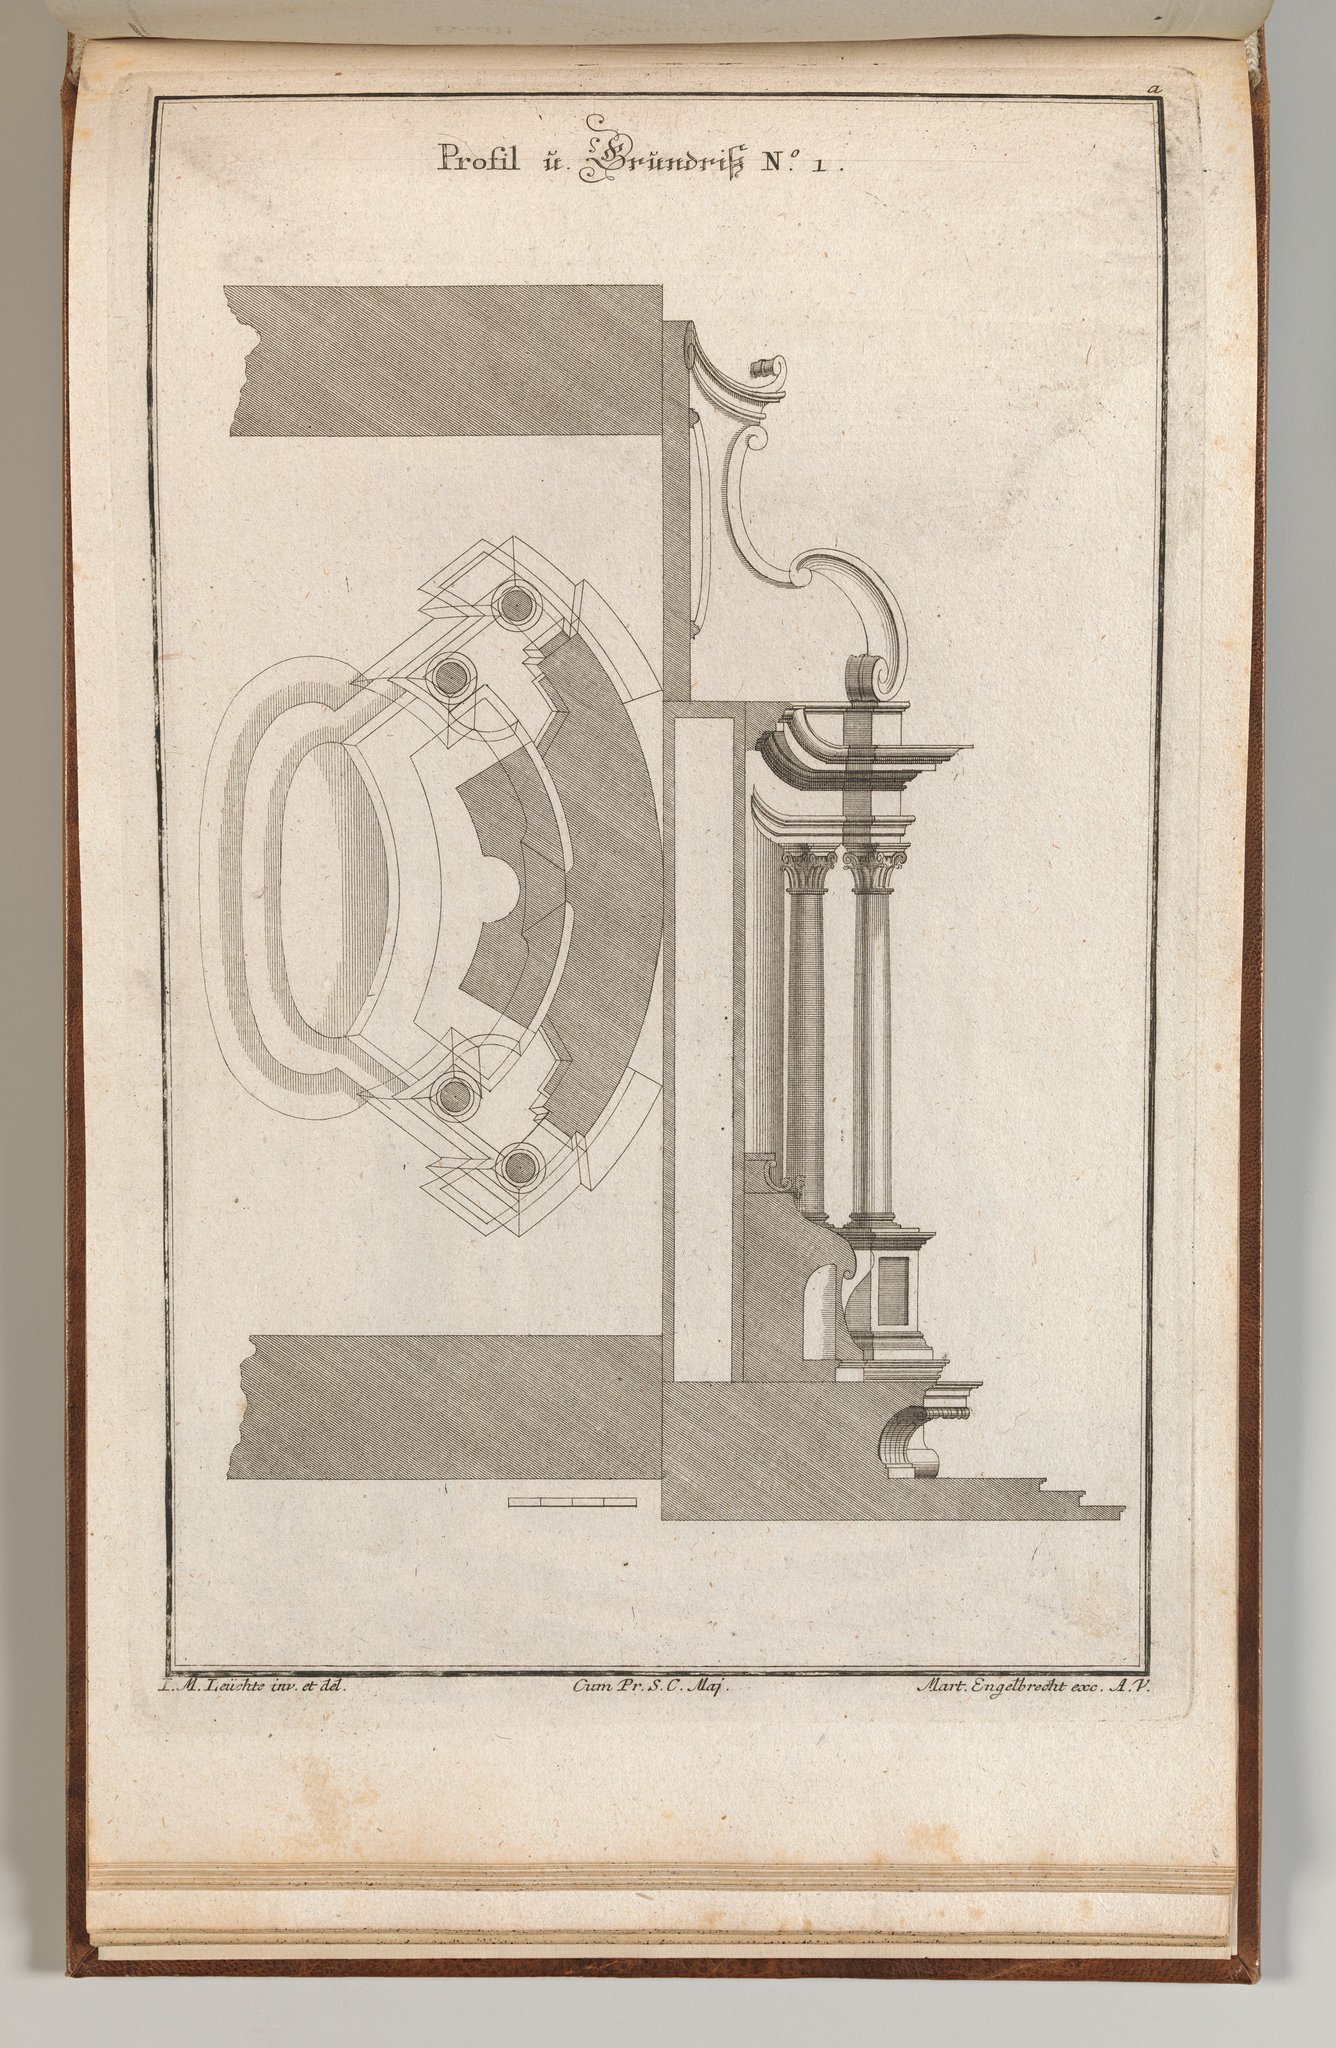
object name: album print ornament architecture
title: Floorplan and Side View of an Altar, Plate a (2) from 'Unterschiedliche Neu Inventierte Altäre mit darzu gehörigen Profillen u. Grundrißen.'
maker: johann michael leüchte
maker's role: artist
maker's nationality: german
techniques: etching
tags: architecture,altars